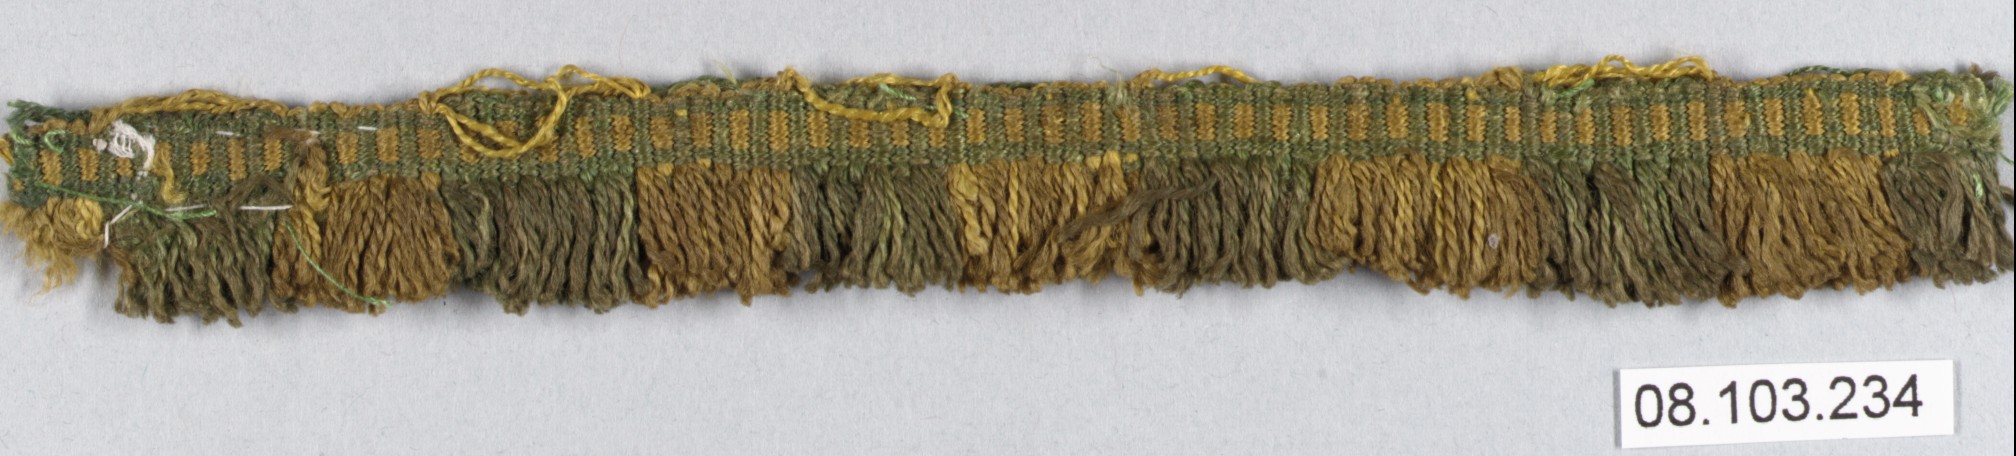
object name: gimp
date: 1701-1800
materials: silk